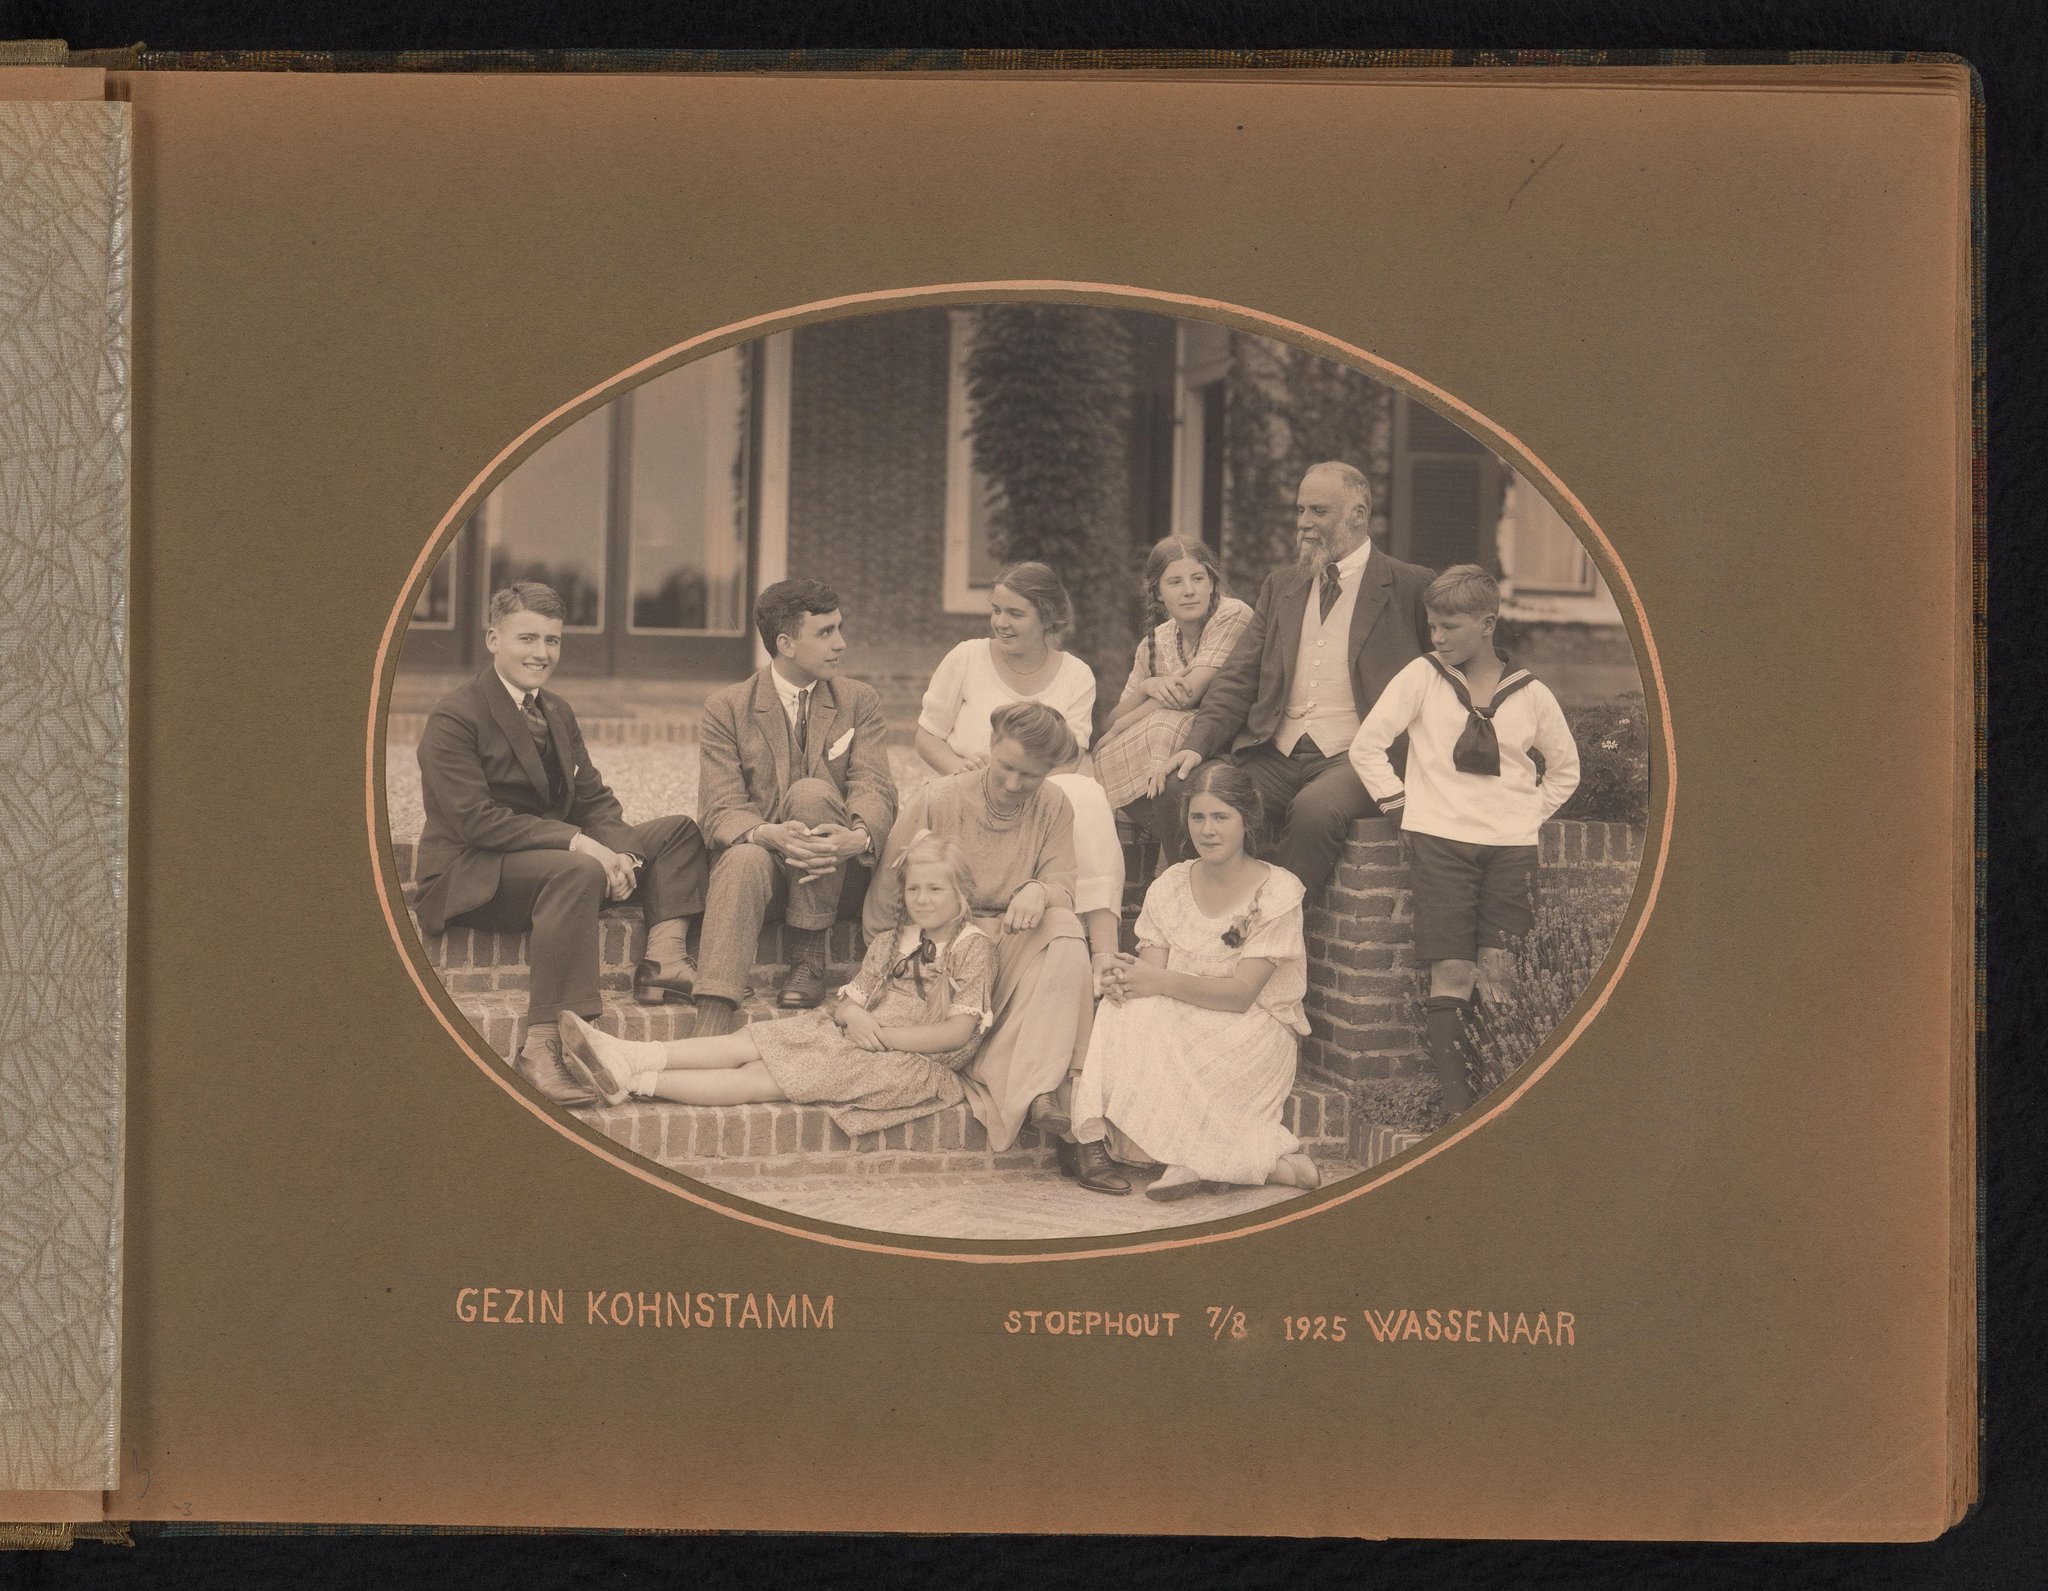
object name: photograph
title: Groepsportret van het gezin van Philip Kohnstamm, met An Kessler en Margaretha, Dinah, Dolph, Johanna en Max Kohnstamm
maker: Anonymous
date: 1925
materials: paper, cardboard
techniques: gelatin silver print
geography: wassenaar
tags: physicist, amsterdam, dinah kohnstamm, historical persons